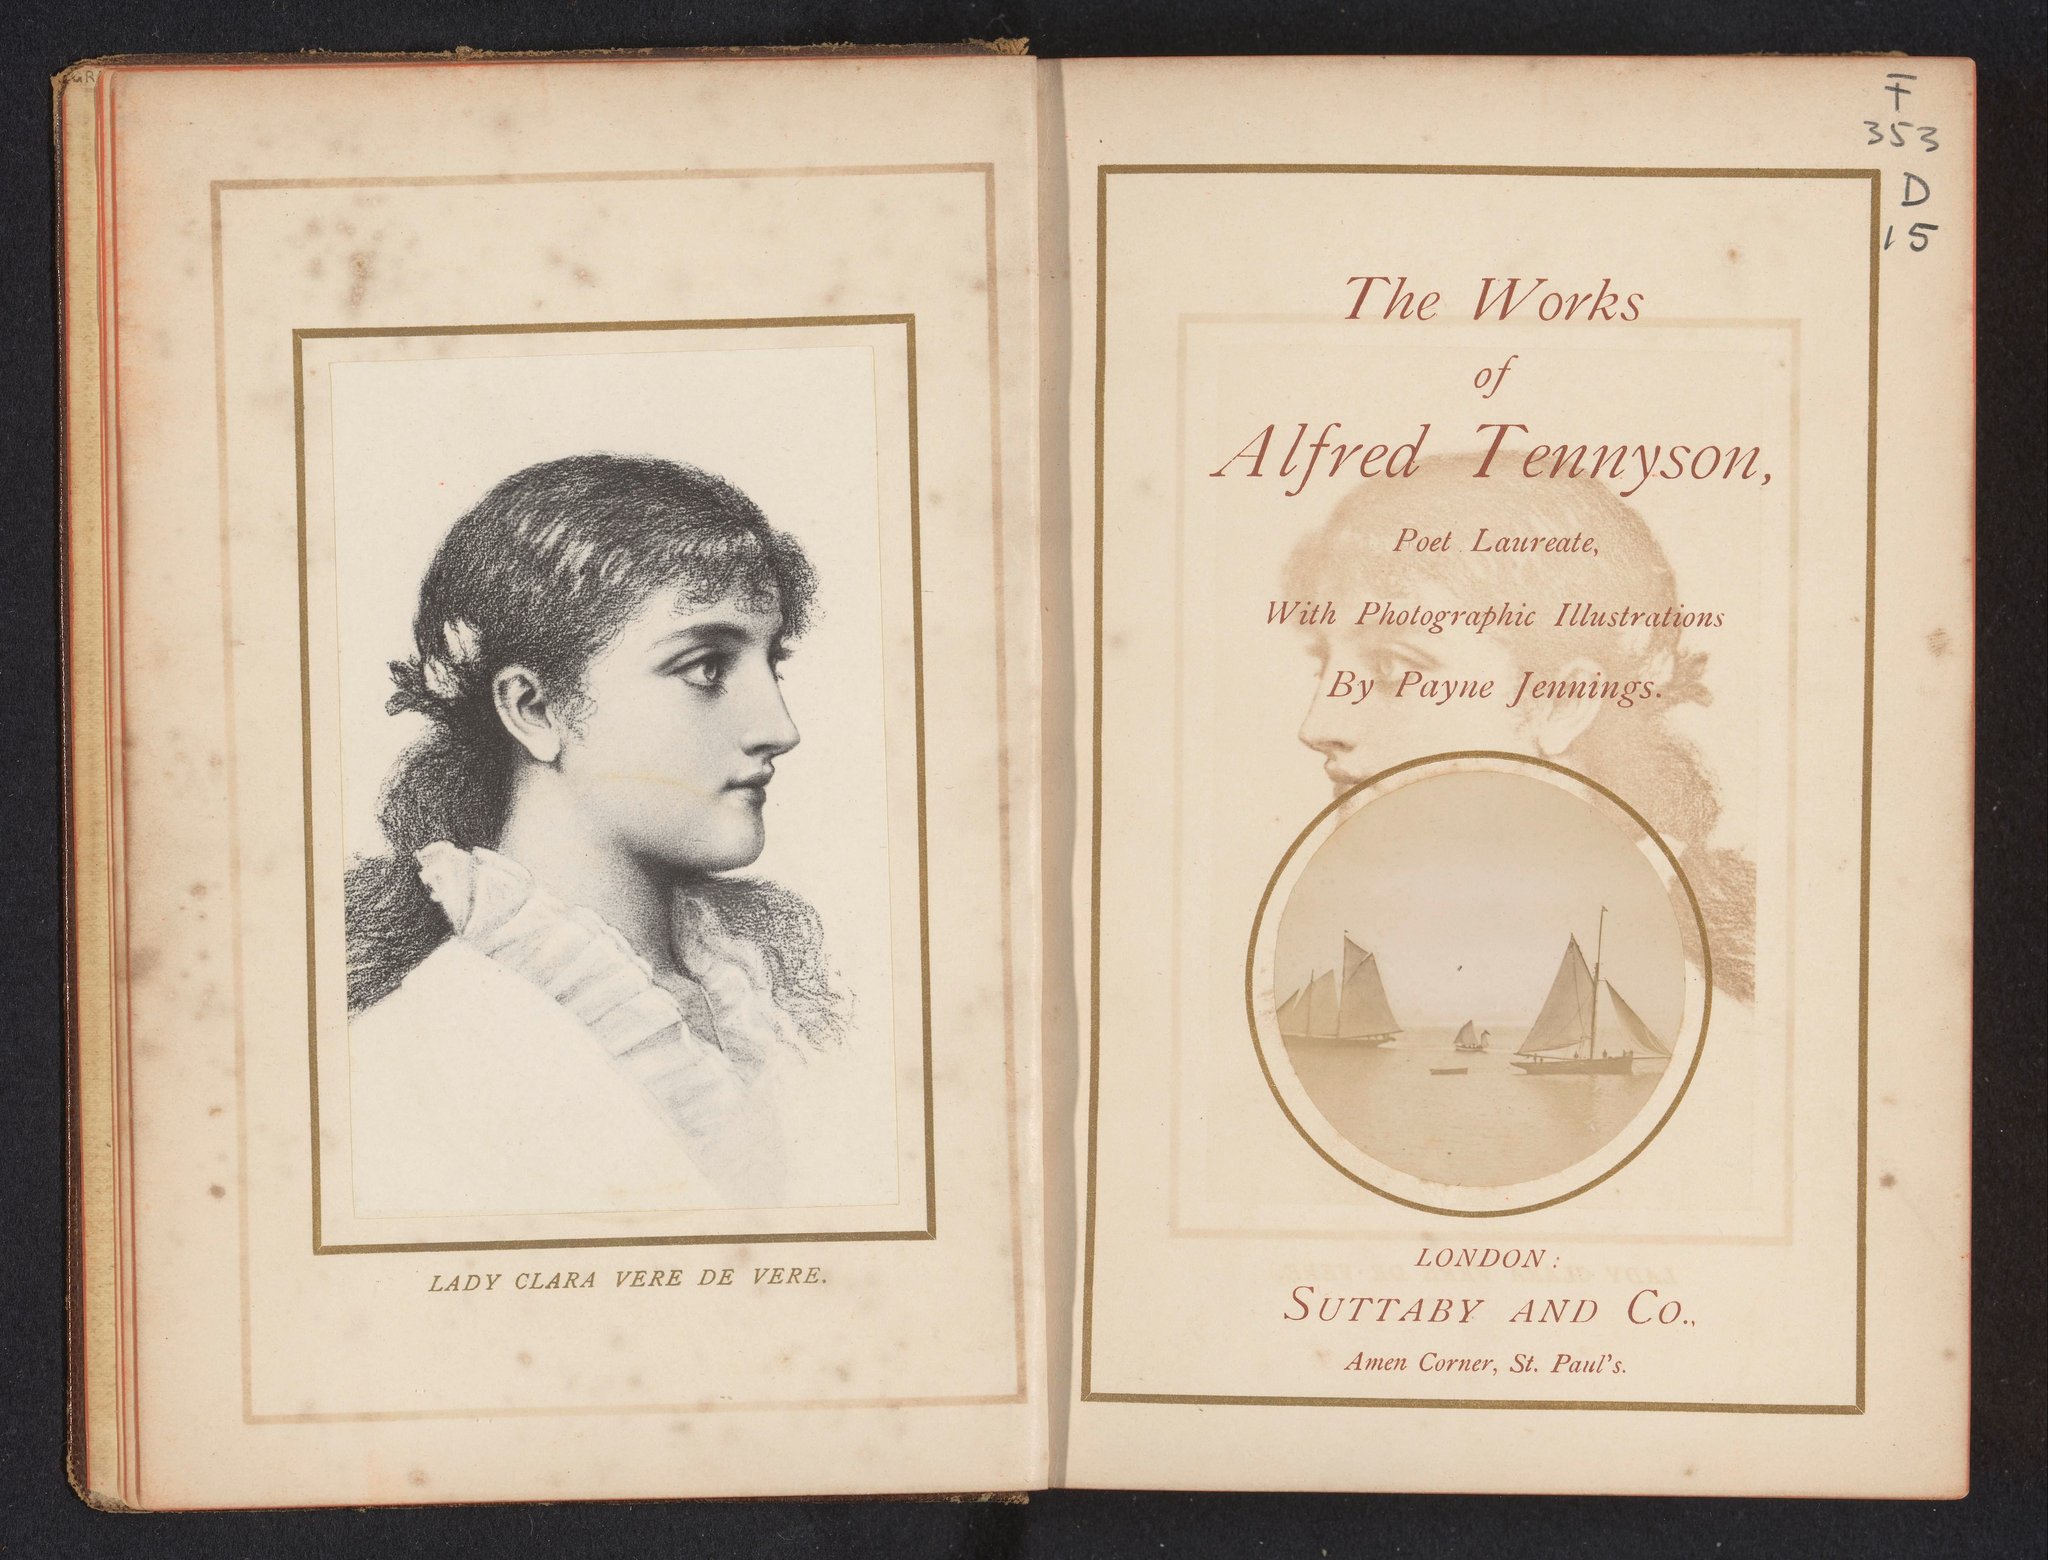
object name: reproduction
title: Lady Clara Vere de Vere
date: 1872-1882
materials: photographic support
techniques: platinum process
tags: print, e.g.: engraving, etching, lithograph